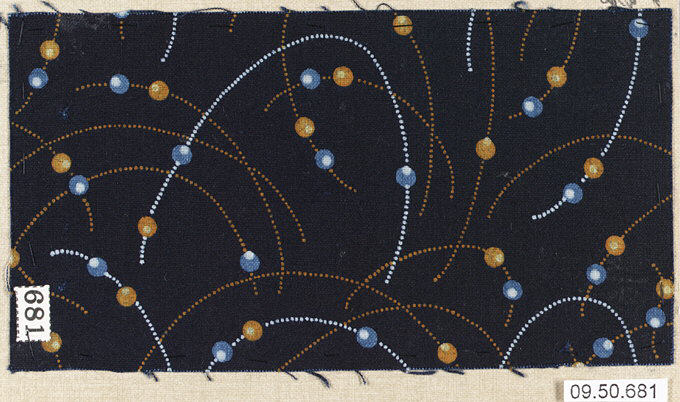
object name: piece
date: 1801-1900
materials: cotton